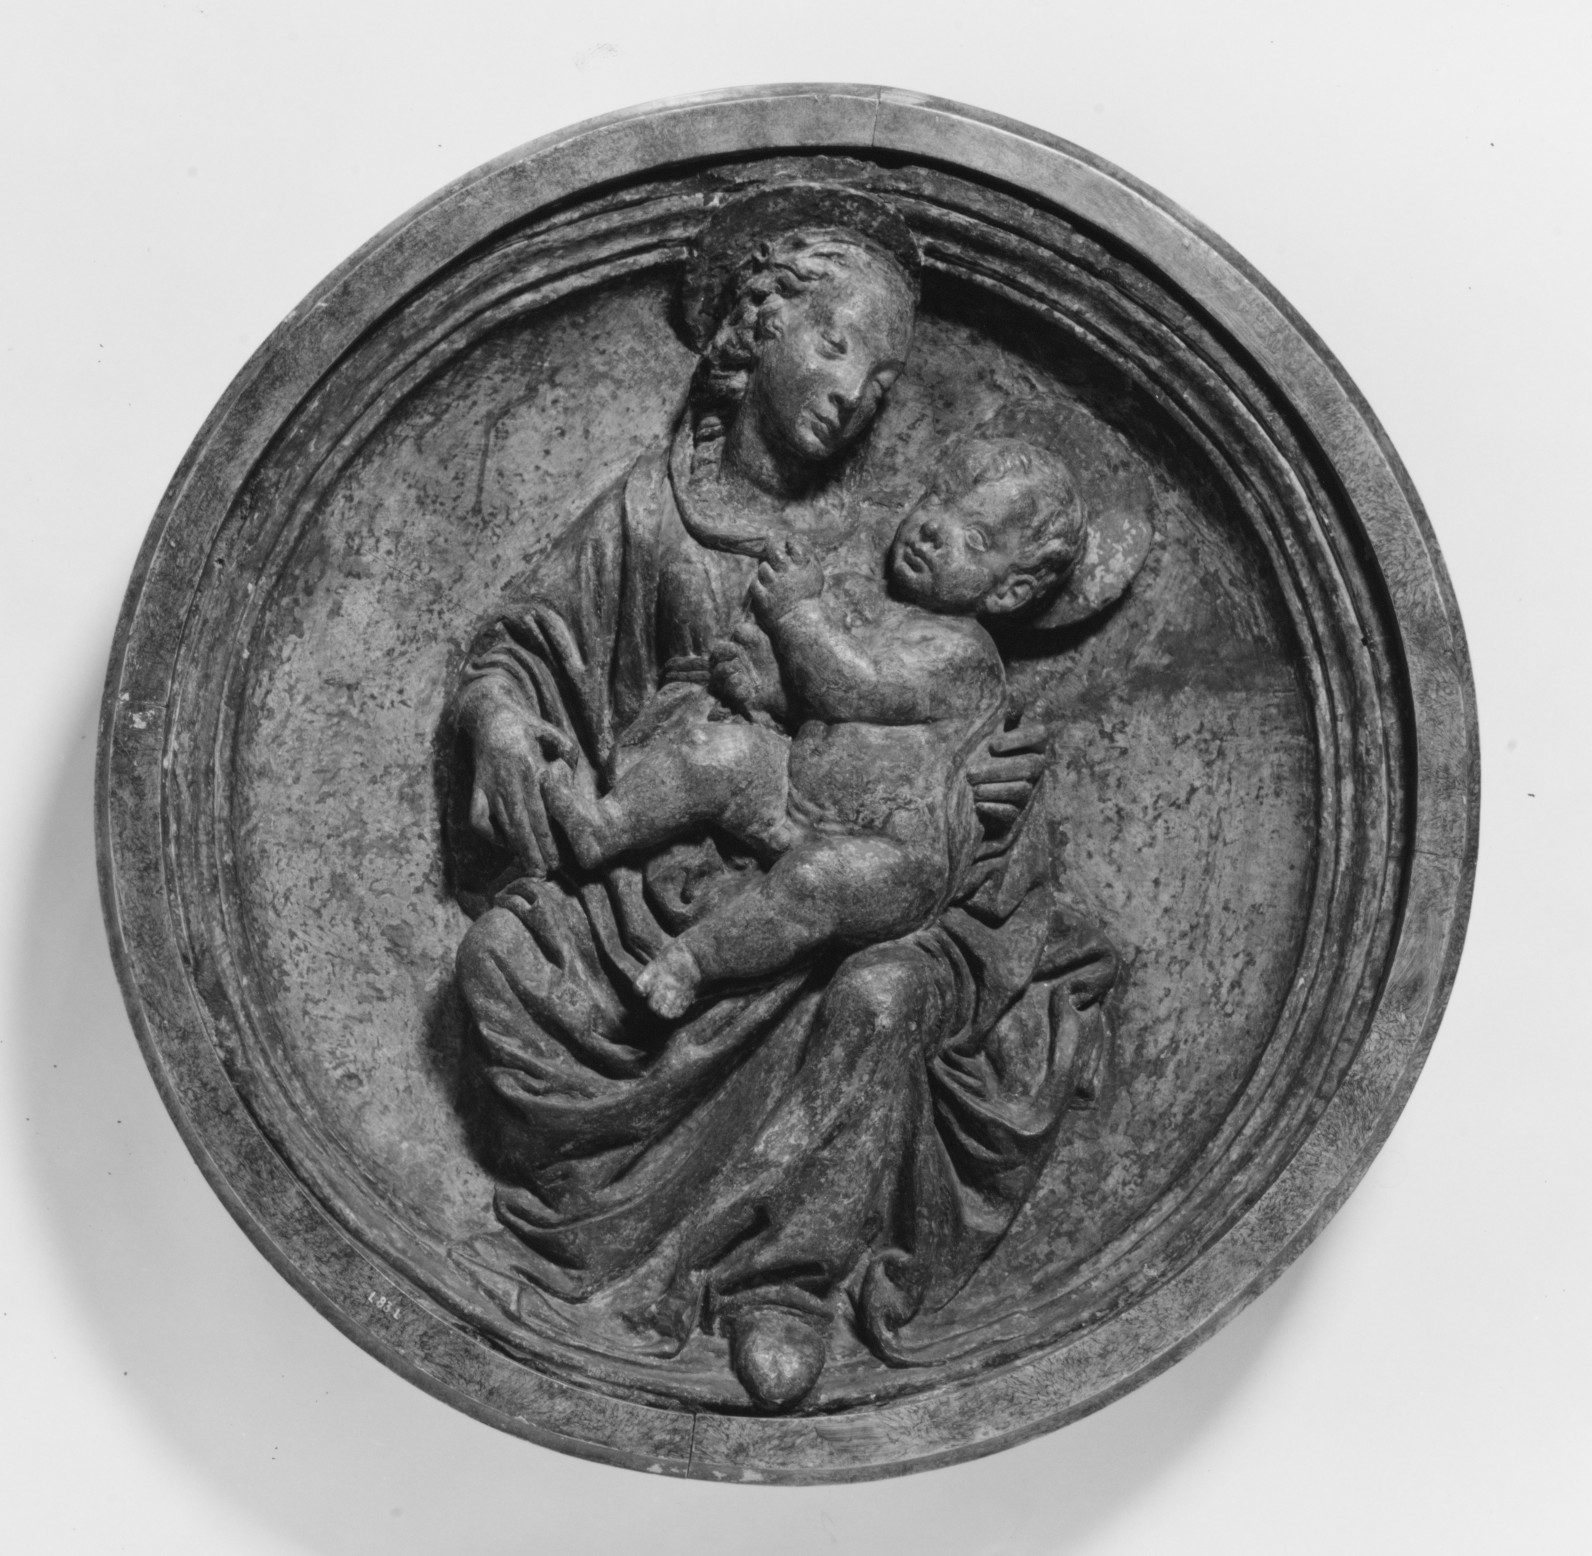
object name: relief tondo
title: Virgin and Child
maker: francesco di simone ferrucci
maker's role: artist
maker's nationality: italian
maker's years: 1437-1493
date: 1467-1500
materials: plaster, wood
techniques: gilding, painting, relief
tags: madonna and child